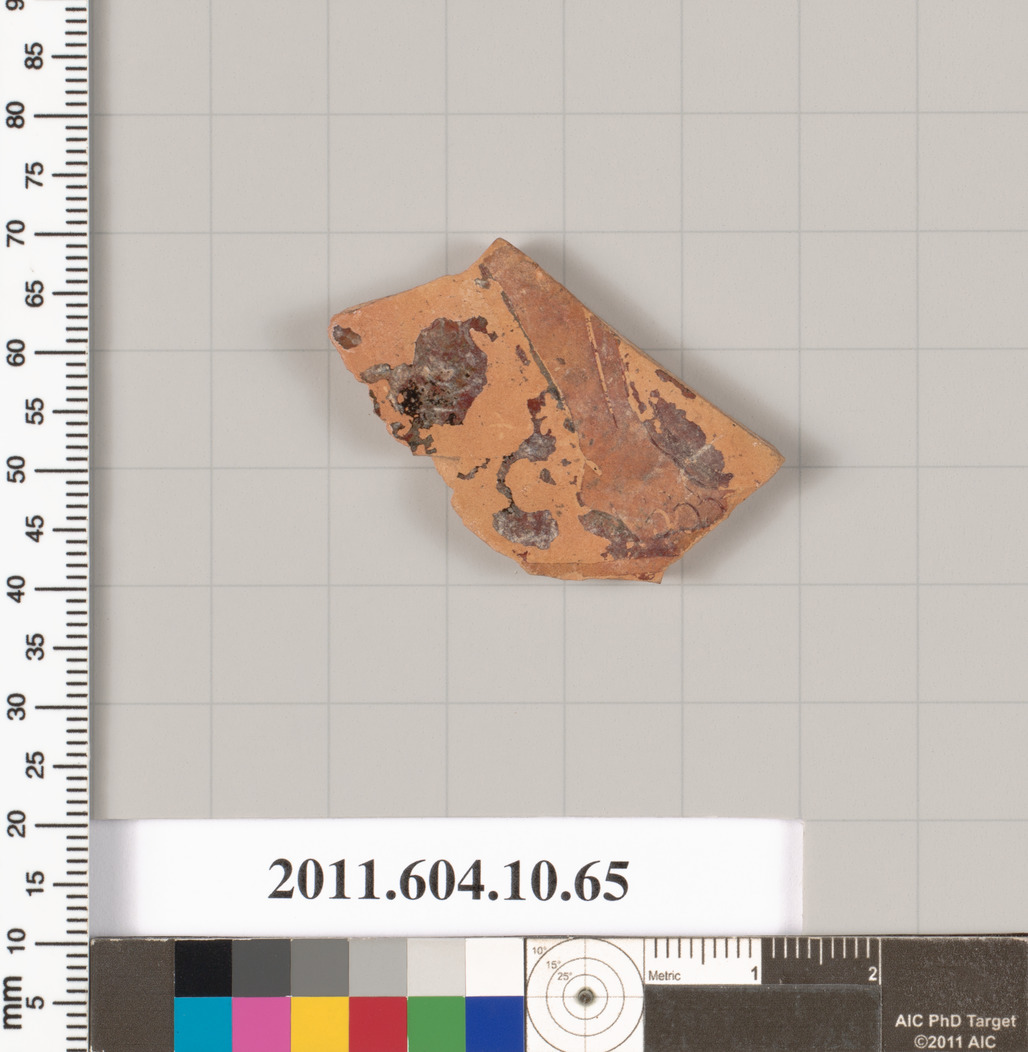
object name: kylix fragment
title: Terracotta fragment of a kylix (drinking cup)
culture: etruscan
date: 334-301 BCE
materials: terracotta